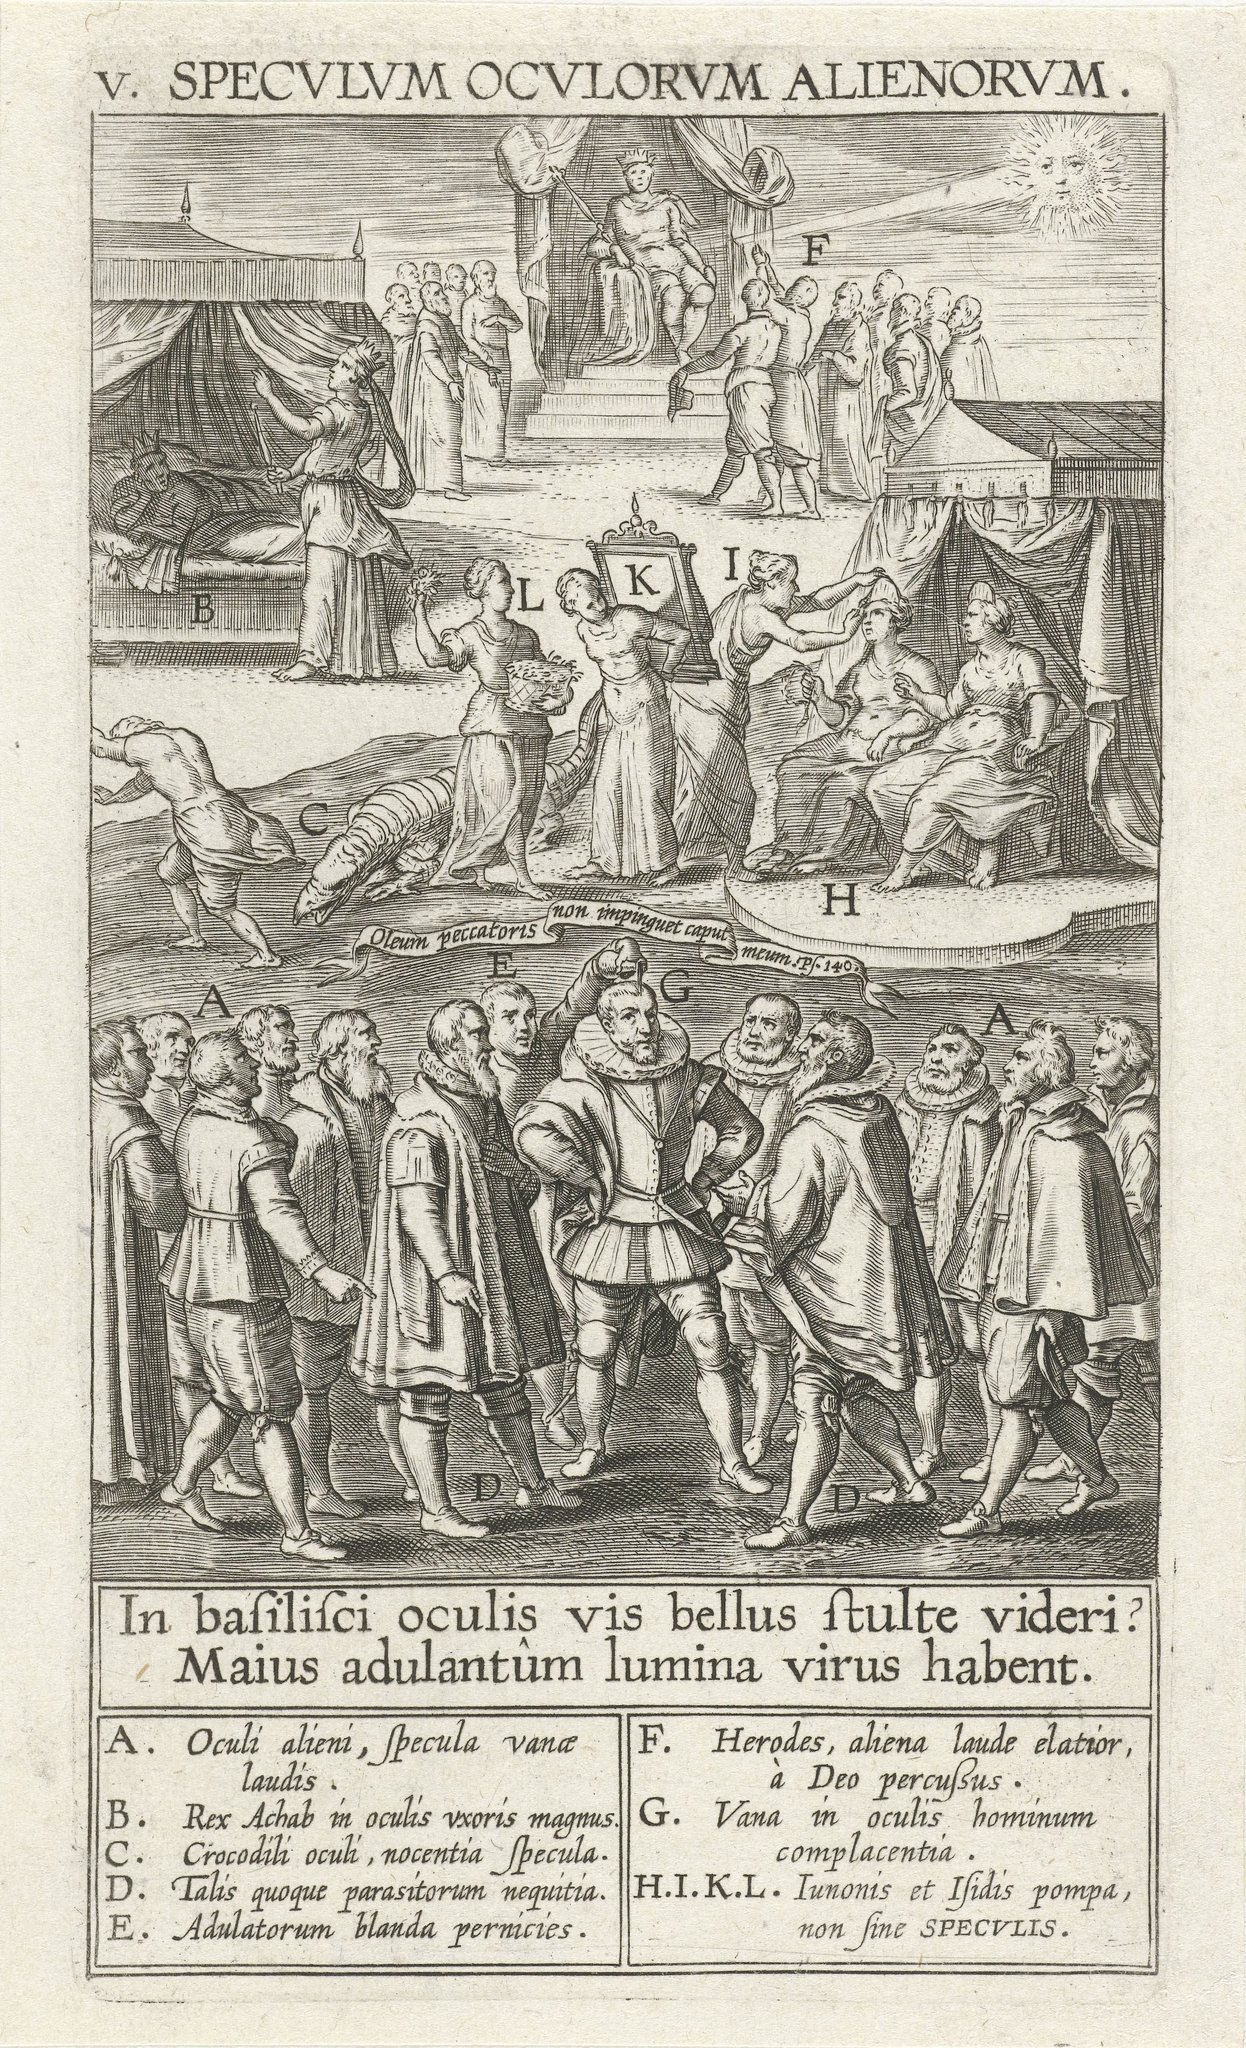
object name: print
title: Spiegel van vermaardheid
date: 1610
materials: paper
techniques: engraving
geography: kortrijk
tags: (story of) juno (hera), crocodiles: crocodile, mirror, story of ahab, son of omri, king of israel, isis, herod (not in biblical context), reflection (in a mirror), anointing the ruler (during coronation)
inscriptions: collector's mark: Lugt 2228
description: Boekillustratie uit Jan David, Duodecim Specula Deum, Antwerpen, 1610.